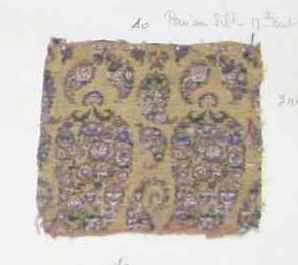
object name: textile fragment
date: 1601-1700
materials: metal thread, silk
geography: iran